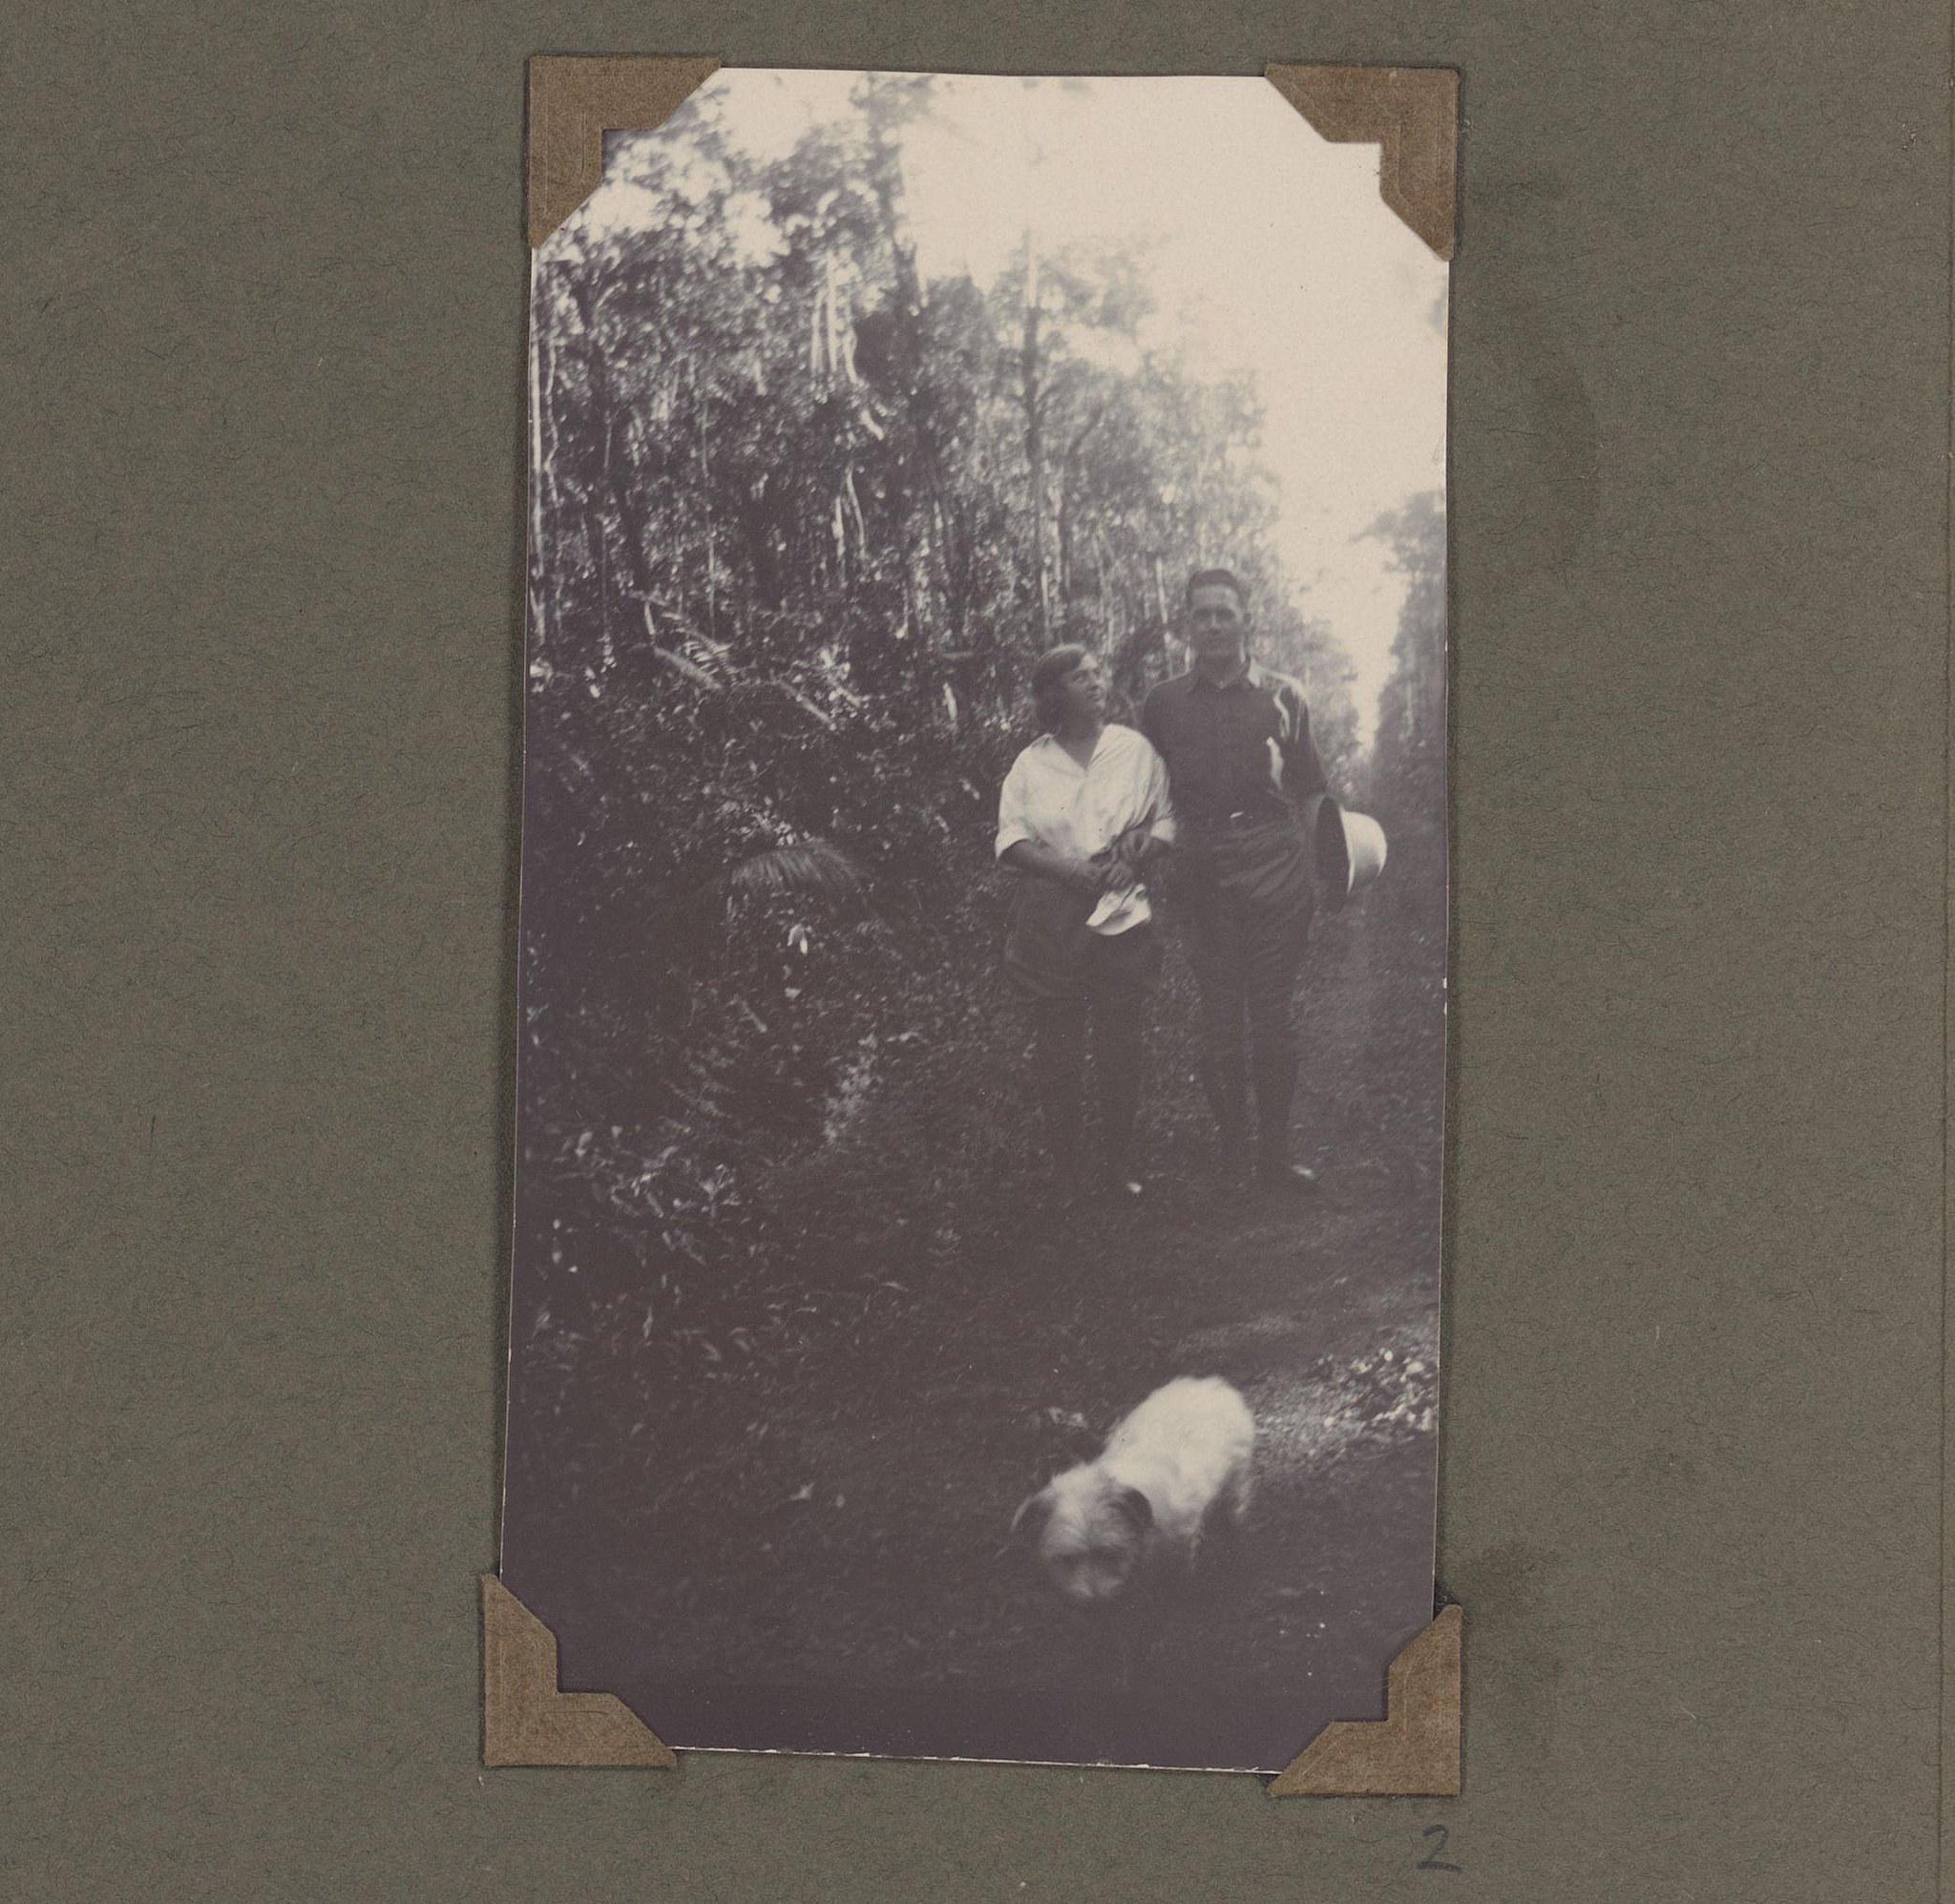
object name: photograph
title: Man en vrouw met hond op een bospad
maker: Anonymous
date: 1925-1927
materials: photographic support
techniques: photography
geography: suriname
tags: jetten, familie, moengo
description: Man en vrouw met hond op een bospad. Foto op een bladzijde van een los albumblad. Onderdeel van het ensemble met foto's van de familie van ingenieur Jetten in de mijnbouwstad Moengo in Suriname.